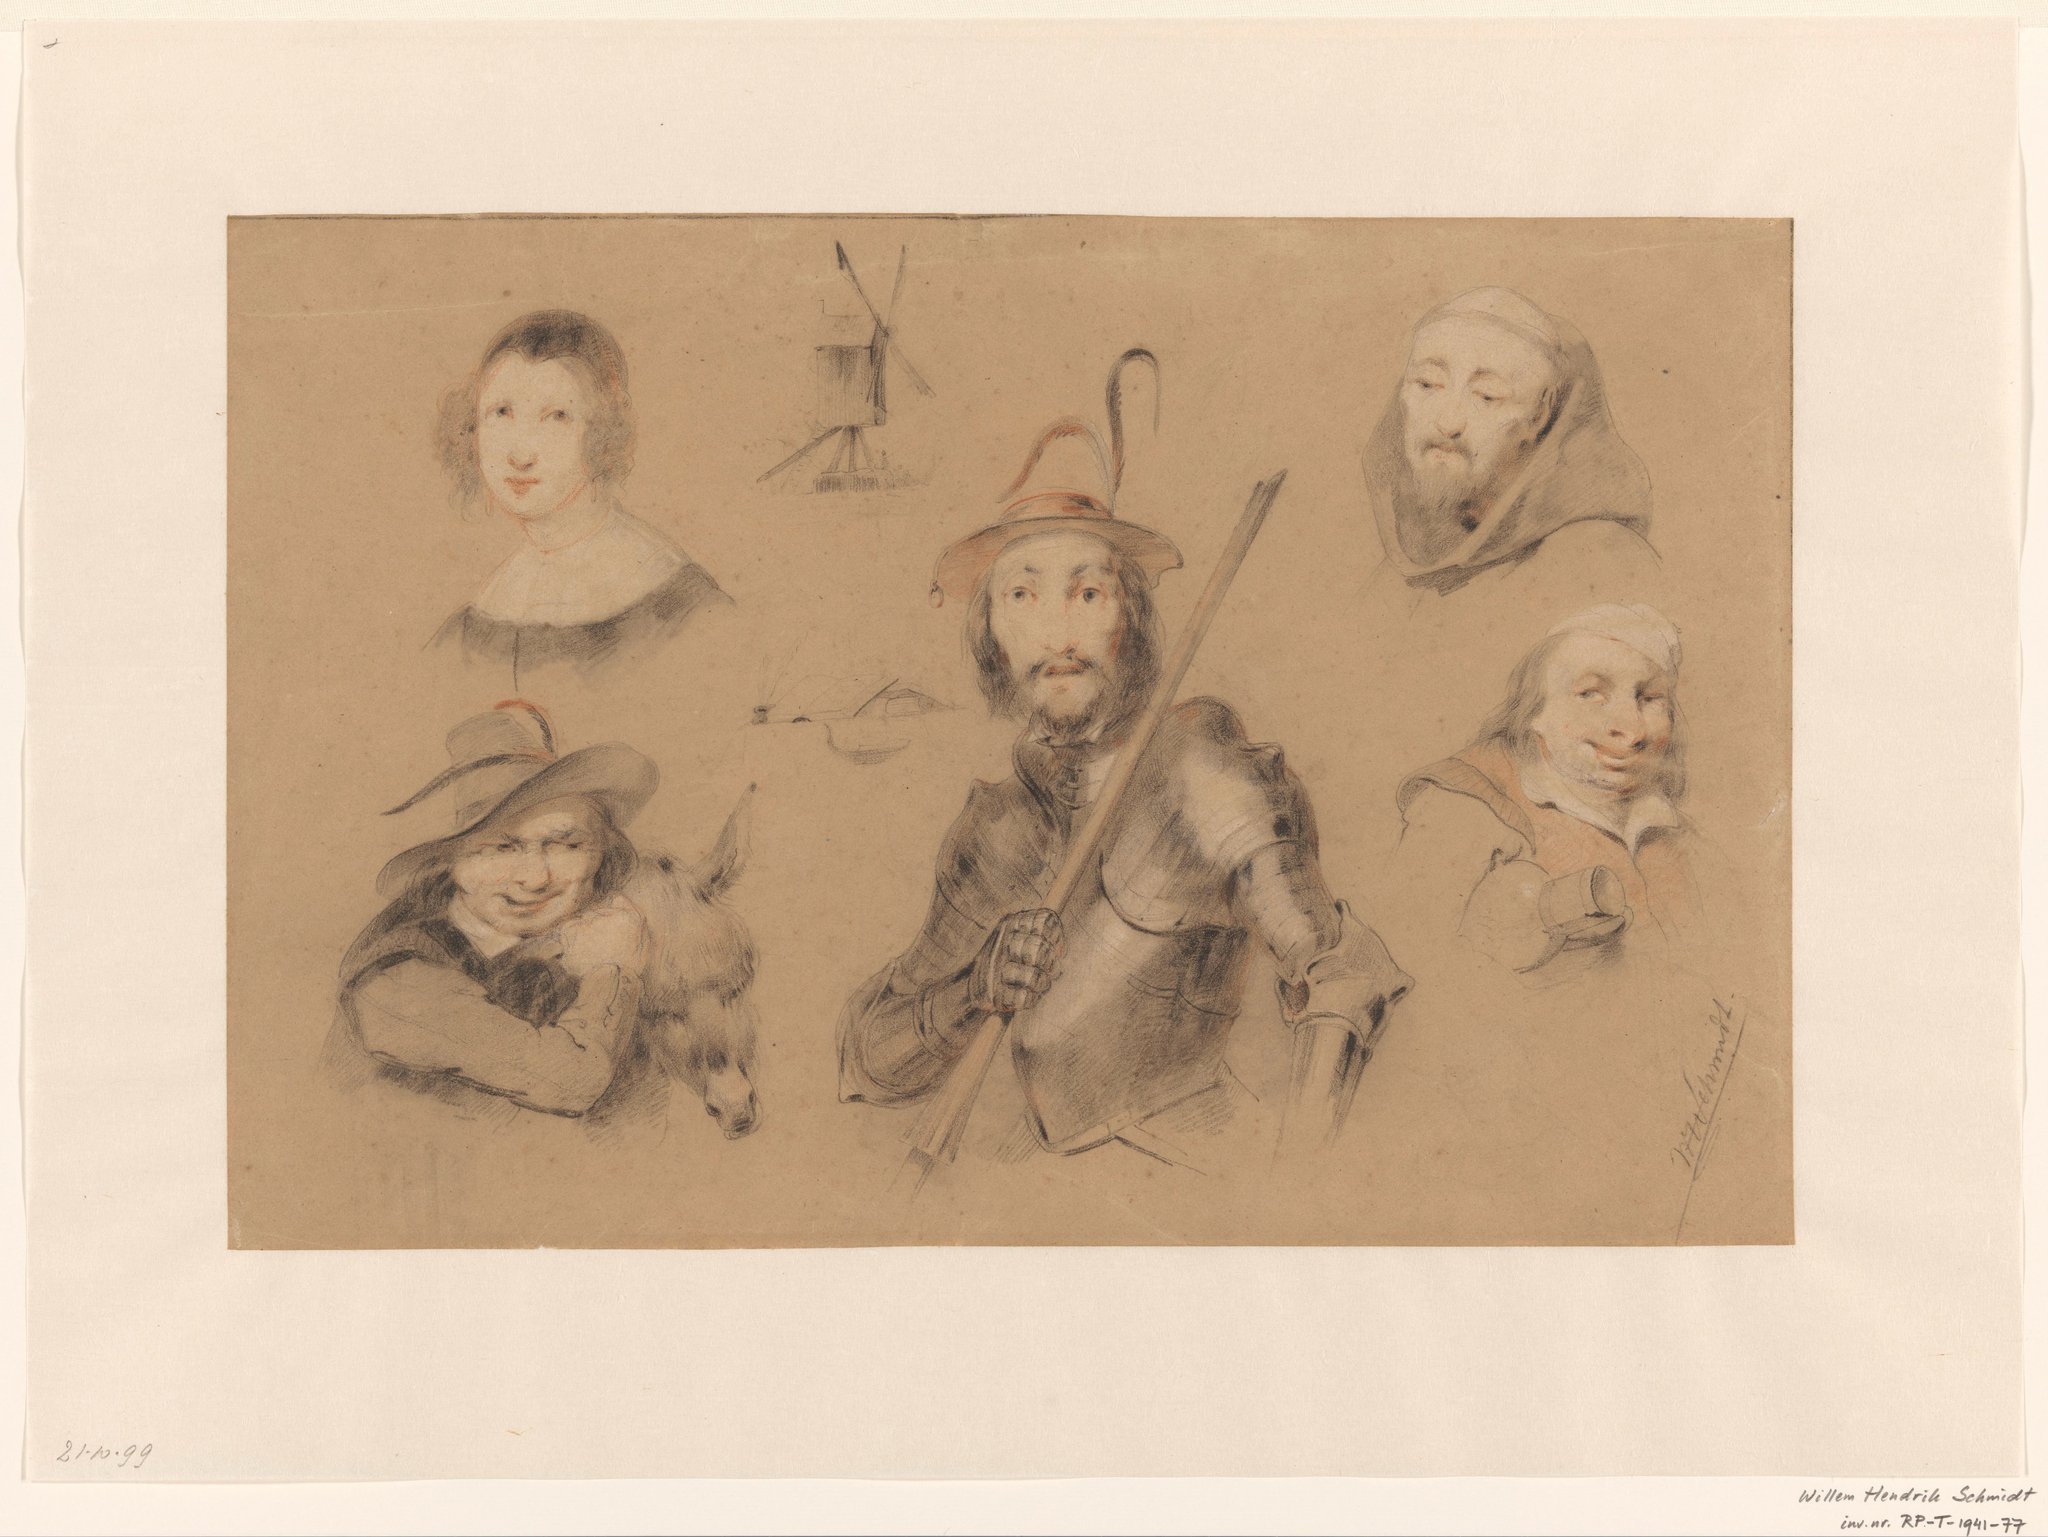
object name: drawing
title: Figuren uit Don Quichot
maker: willem hendrik schmidt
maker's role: draughtsman, painter, print maker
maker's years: 1809-1849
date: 1819-1849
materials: chalk, paper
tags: (scenes from) specific works of literature (with author, title), don quixote, sancho panza